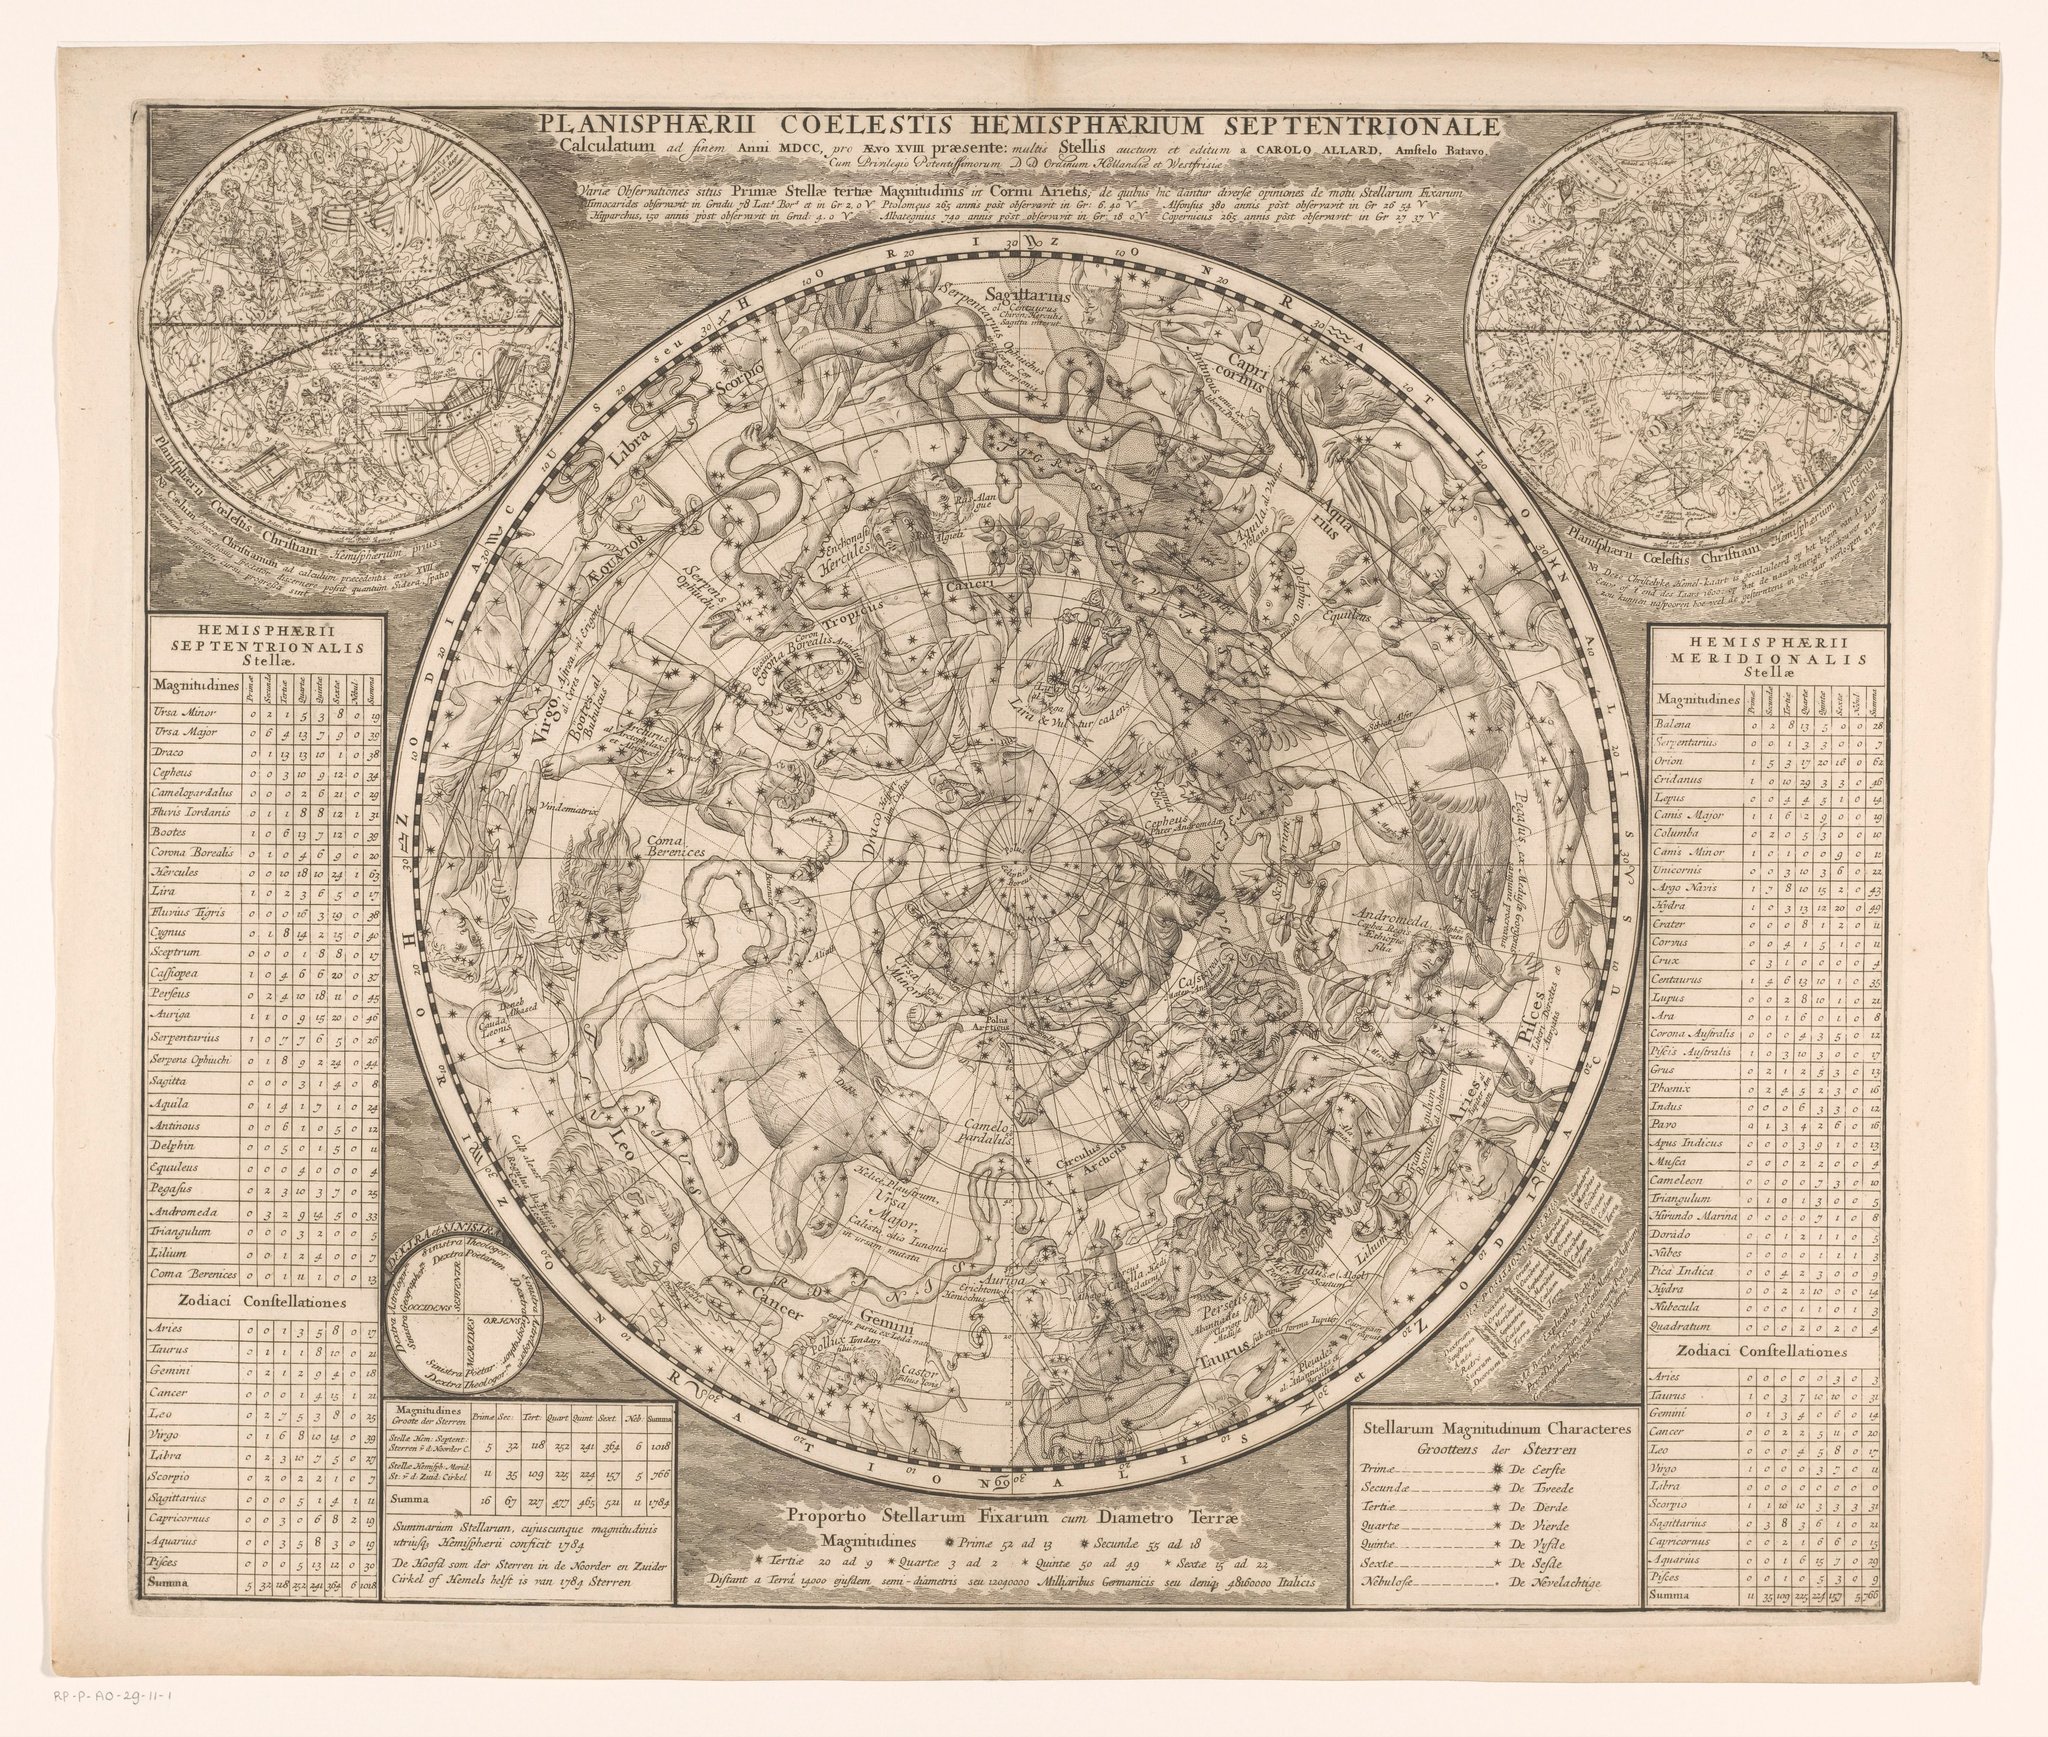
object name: map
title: Hemelkaart met de noordelijke sterrenbeelden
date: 1706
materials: paper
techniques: engraving, etching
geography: amsterdam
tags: zodiac; the twelve zodiacal signs together, star-chart, star map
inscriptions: collector's mark: Lugt 2228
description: Hemelkaart met de noordelijke sterrenbeelden, volgens de traditionele indeling van Ptolemaeus en zijn navolgers. Links- en rechtsboven hemelkaarten met de Christelijke sterrenbeelden naar Julius Schiller. Links en rechts van de kaart tabellen met een overzicht van het aantal sterren per sterrenbeeld. Onder, in het midden, en onder, rechts van het midden, een legenda.